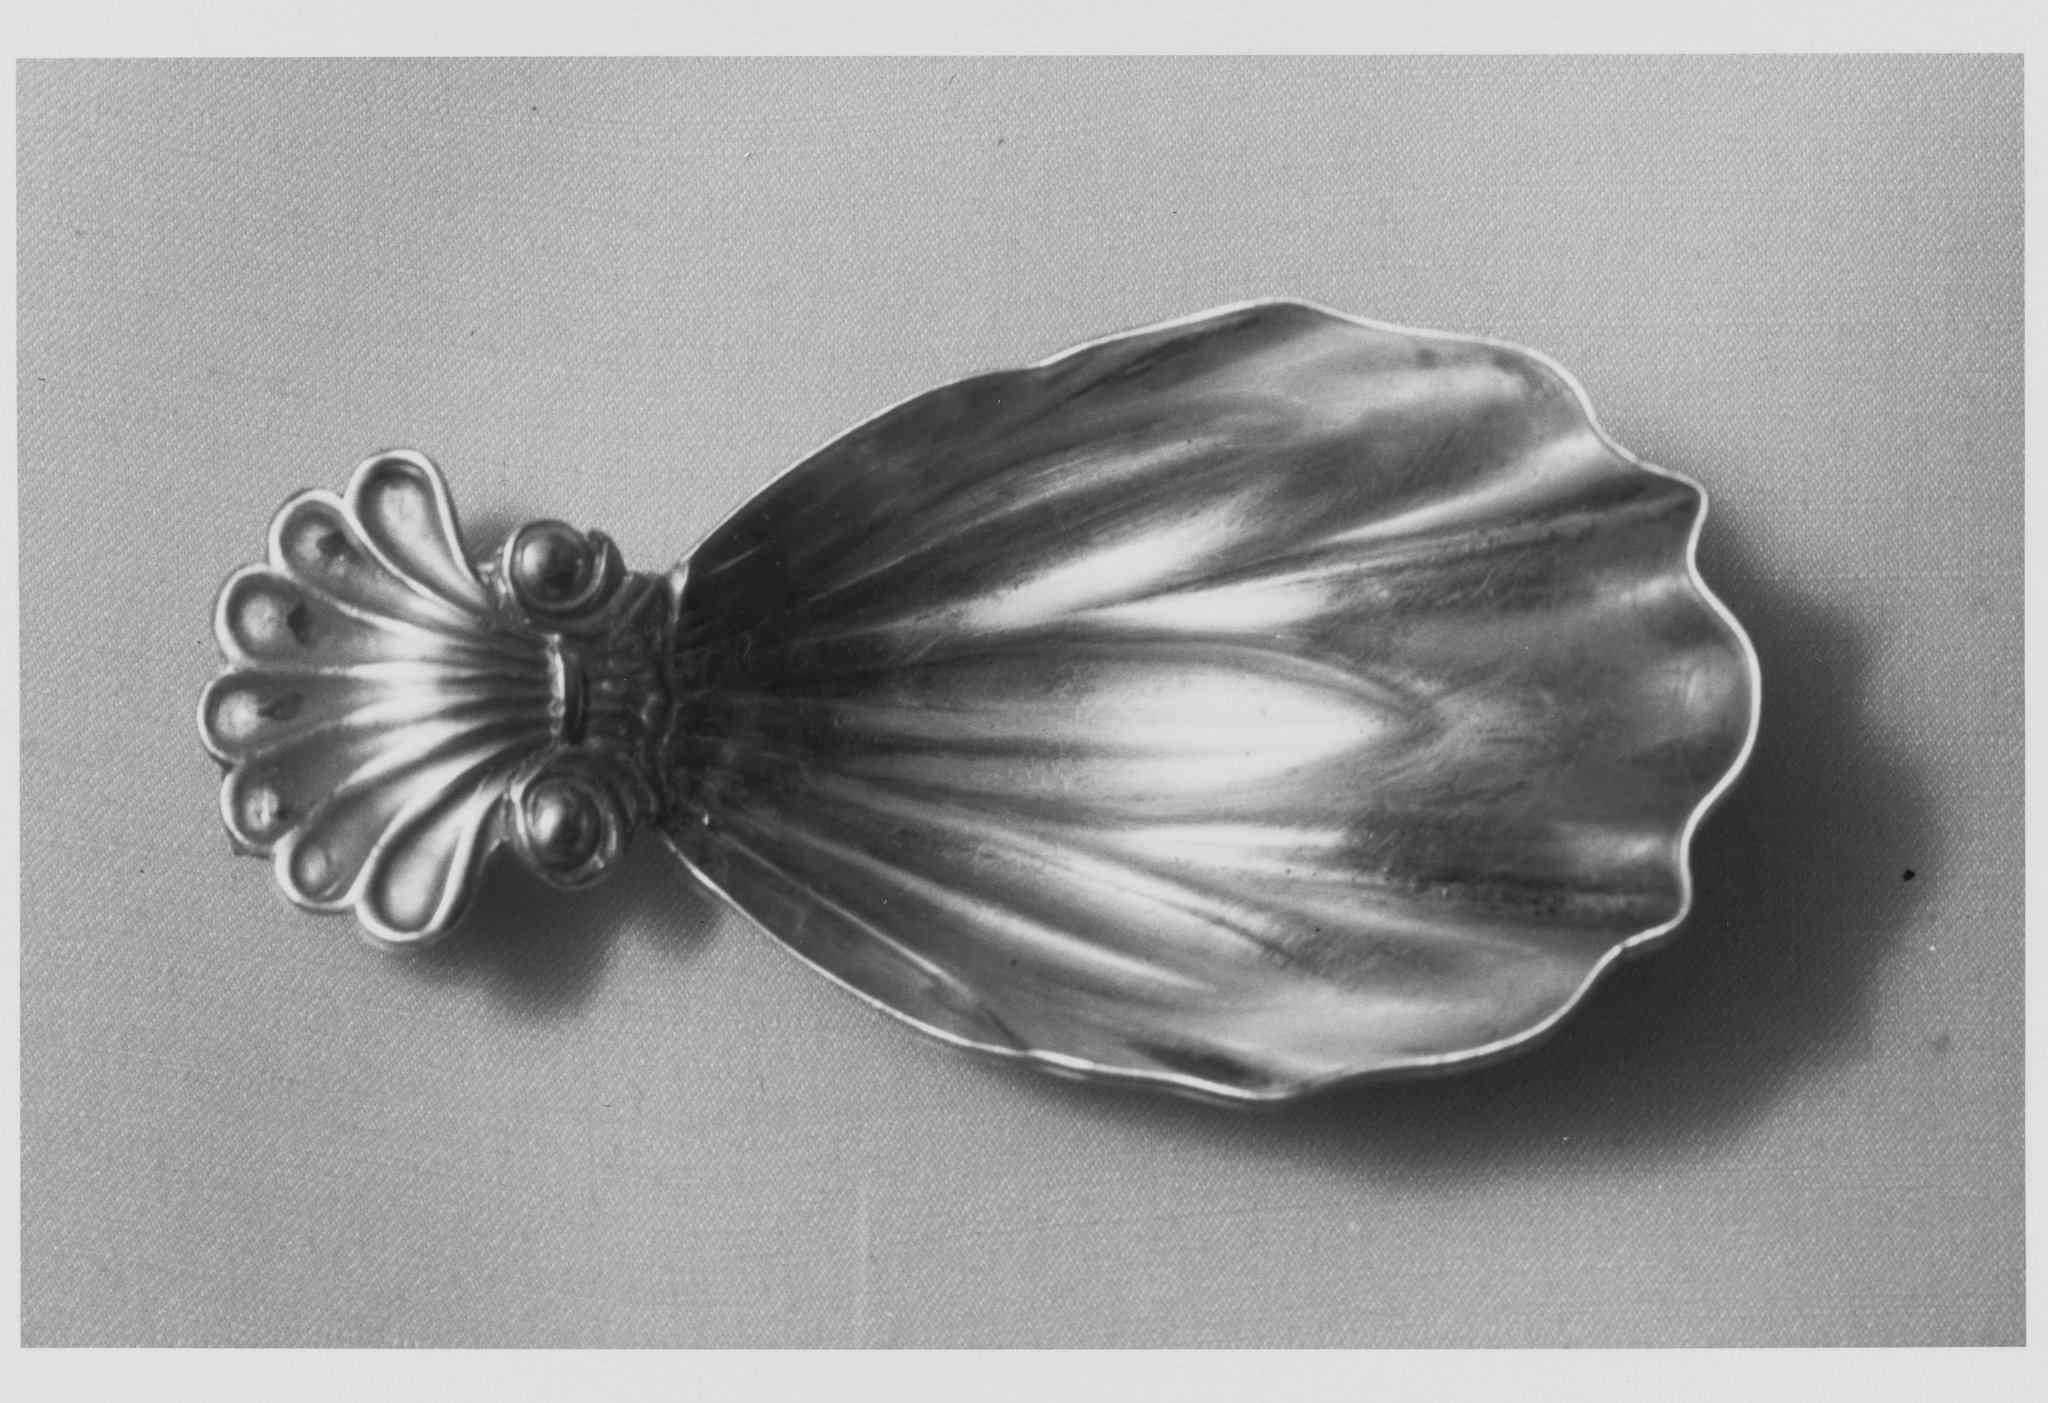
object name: caddy spoon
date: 1817-1818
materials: silver